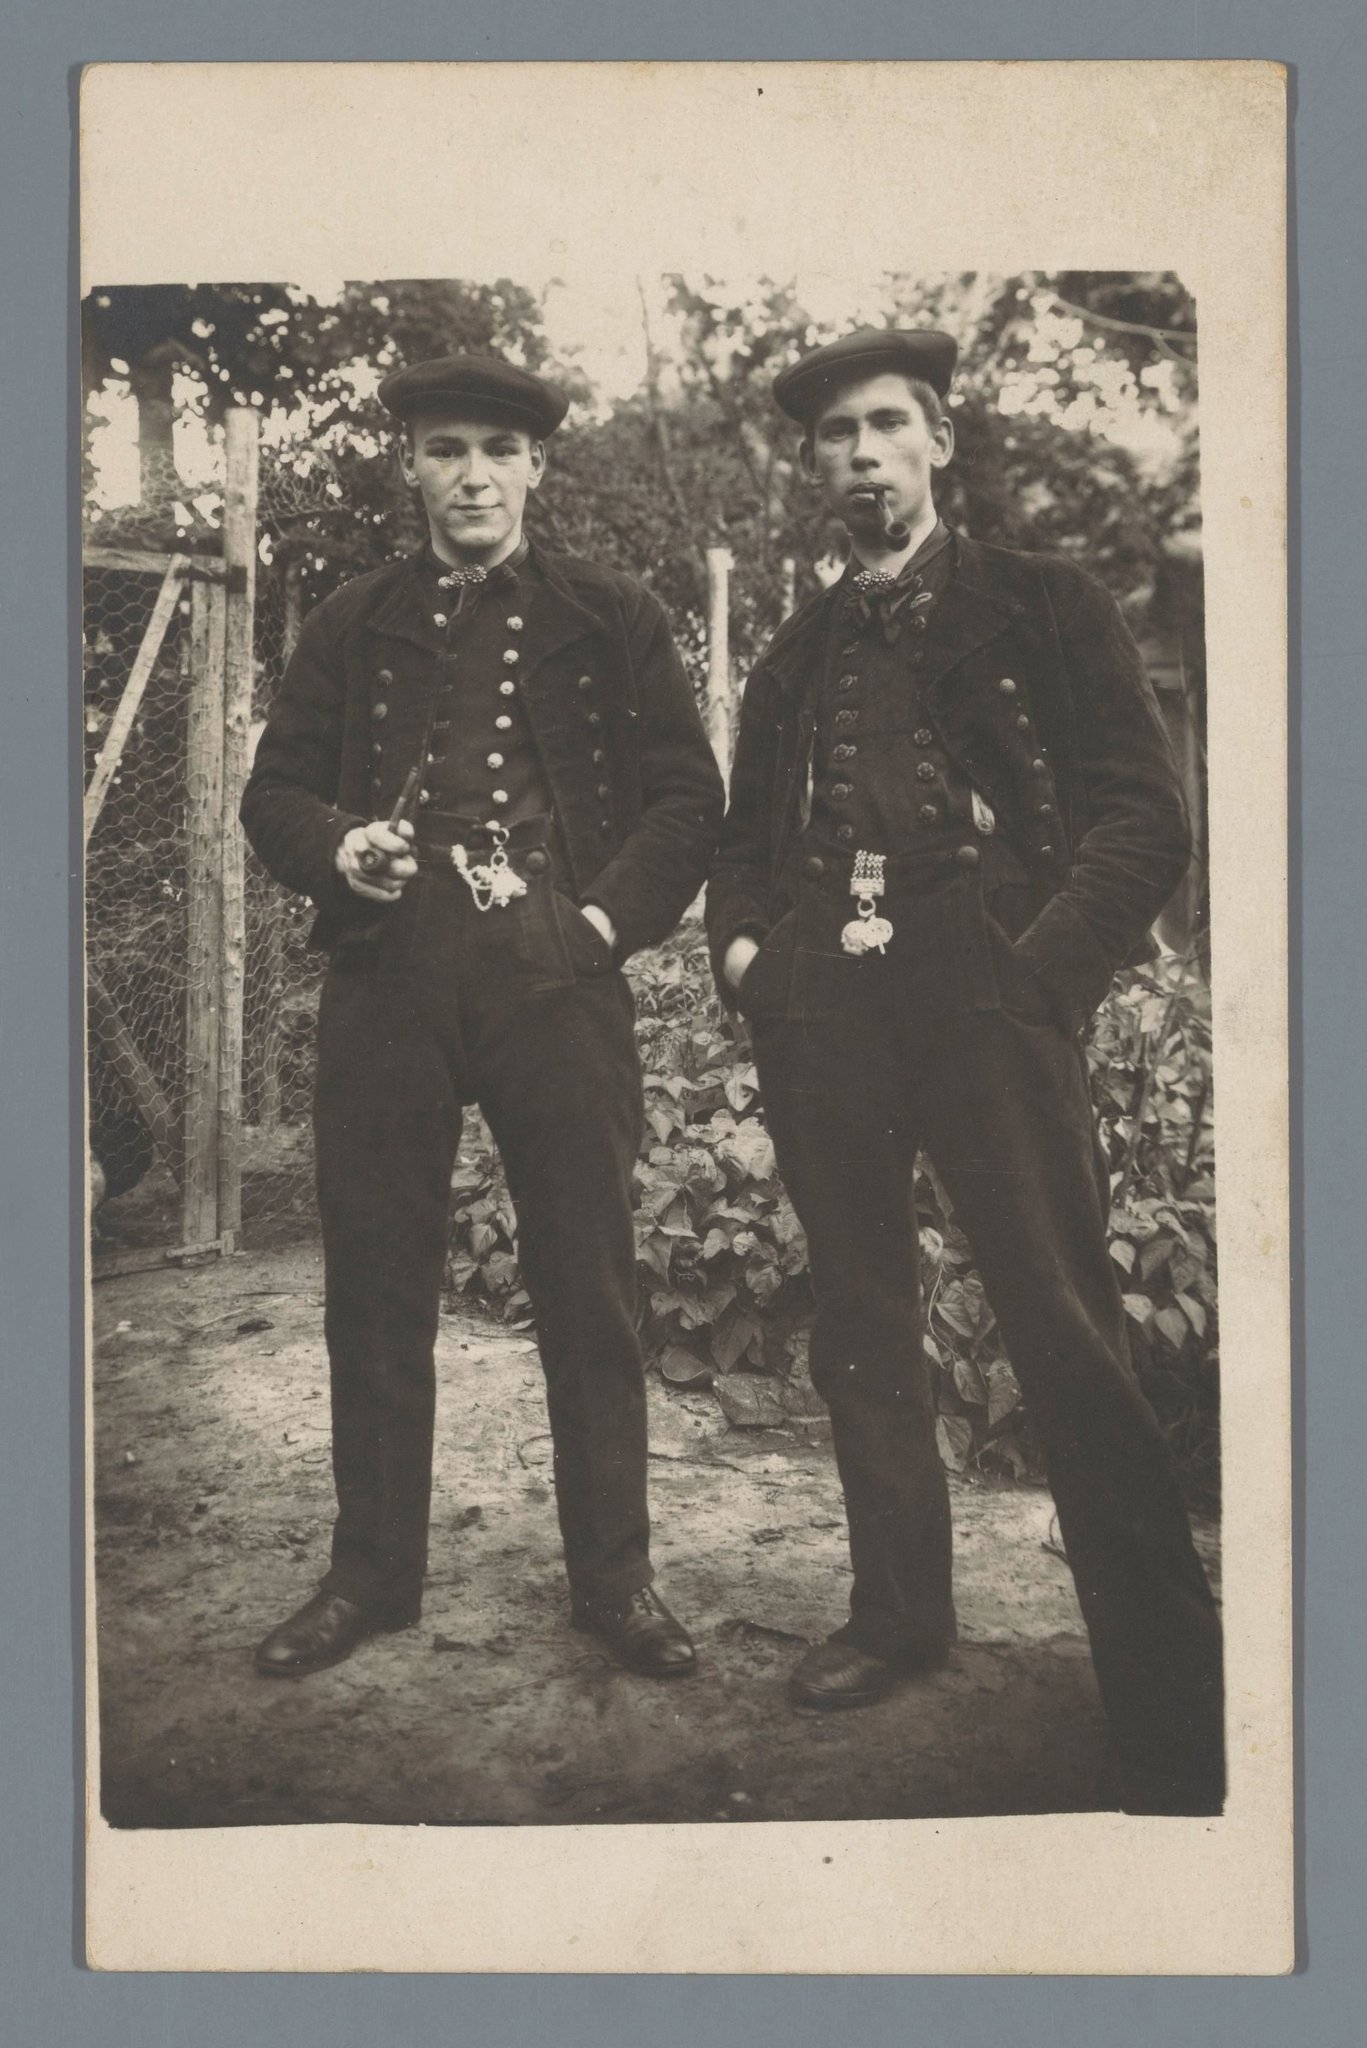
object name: ansichtkaart, prentbriefkaart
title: Portret van twee onbekende mannen in klederdracht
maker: Anonymous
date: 1907-1920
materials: photographic support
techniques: gelatin silver print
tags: adult man, folk costume, regional costume